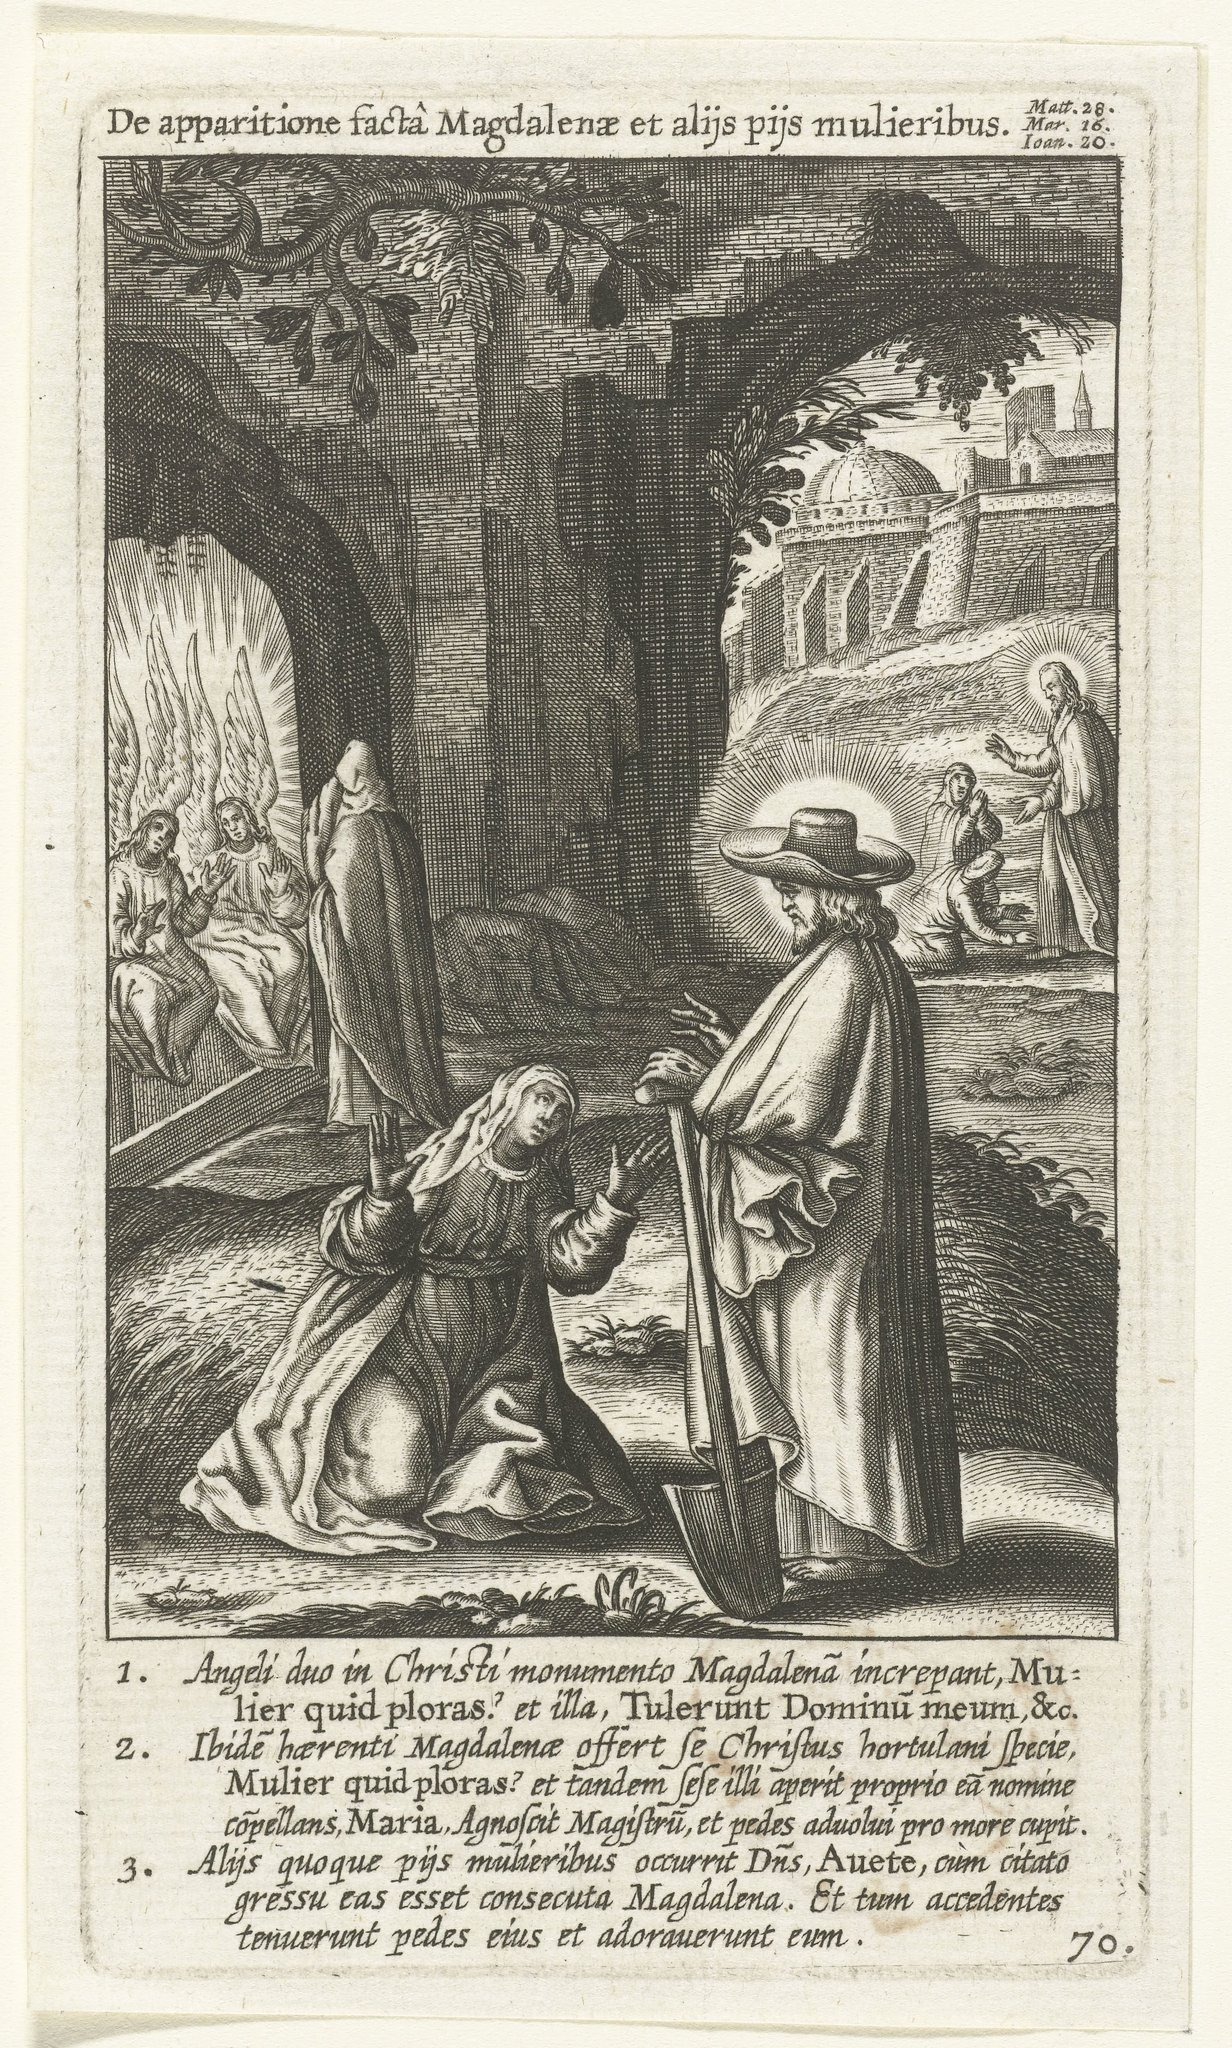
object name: book illustration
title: Maria Magdalena knielt voor Christus die is gekleed als een tuinman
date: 1590-1622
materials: paper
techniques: engraving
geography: antwerp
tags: mary magdalene kneeling before christ, who is usually represented as a gardener with a hoe and/or a spade; 'noli me tangere'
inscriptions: collector's mark: Lugt 240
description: Prent uit: Joannes Bourgois, Vitae passionis et mortis Jesu Christi Somini nostri mysteria, Antwerpen Hendrick Aertssens, 1622, afb. 70